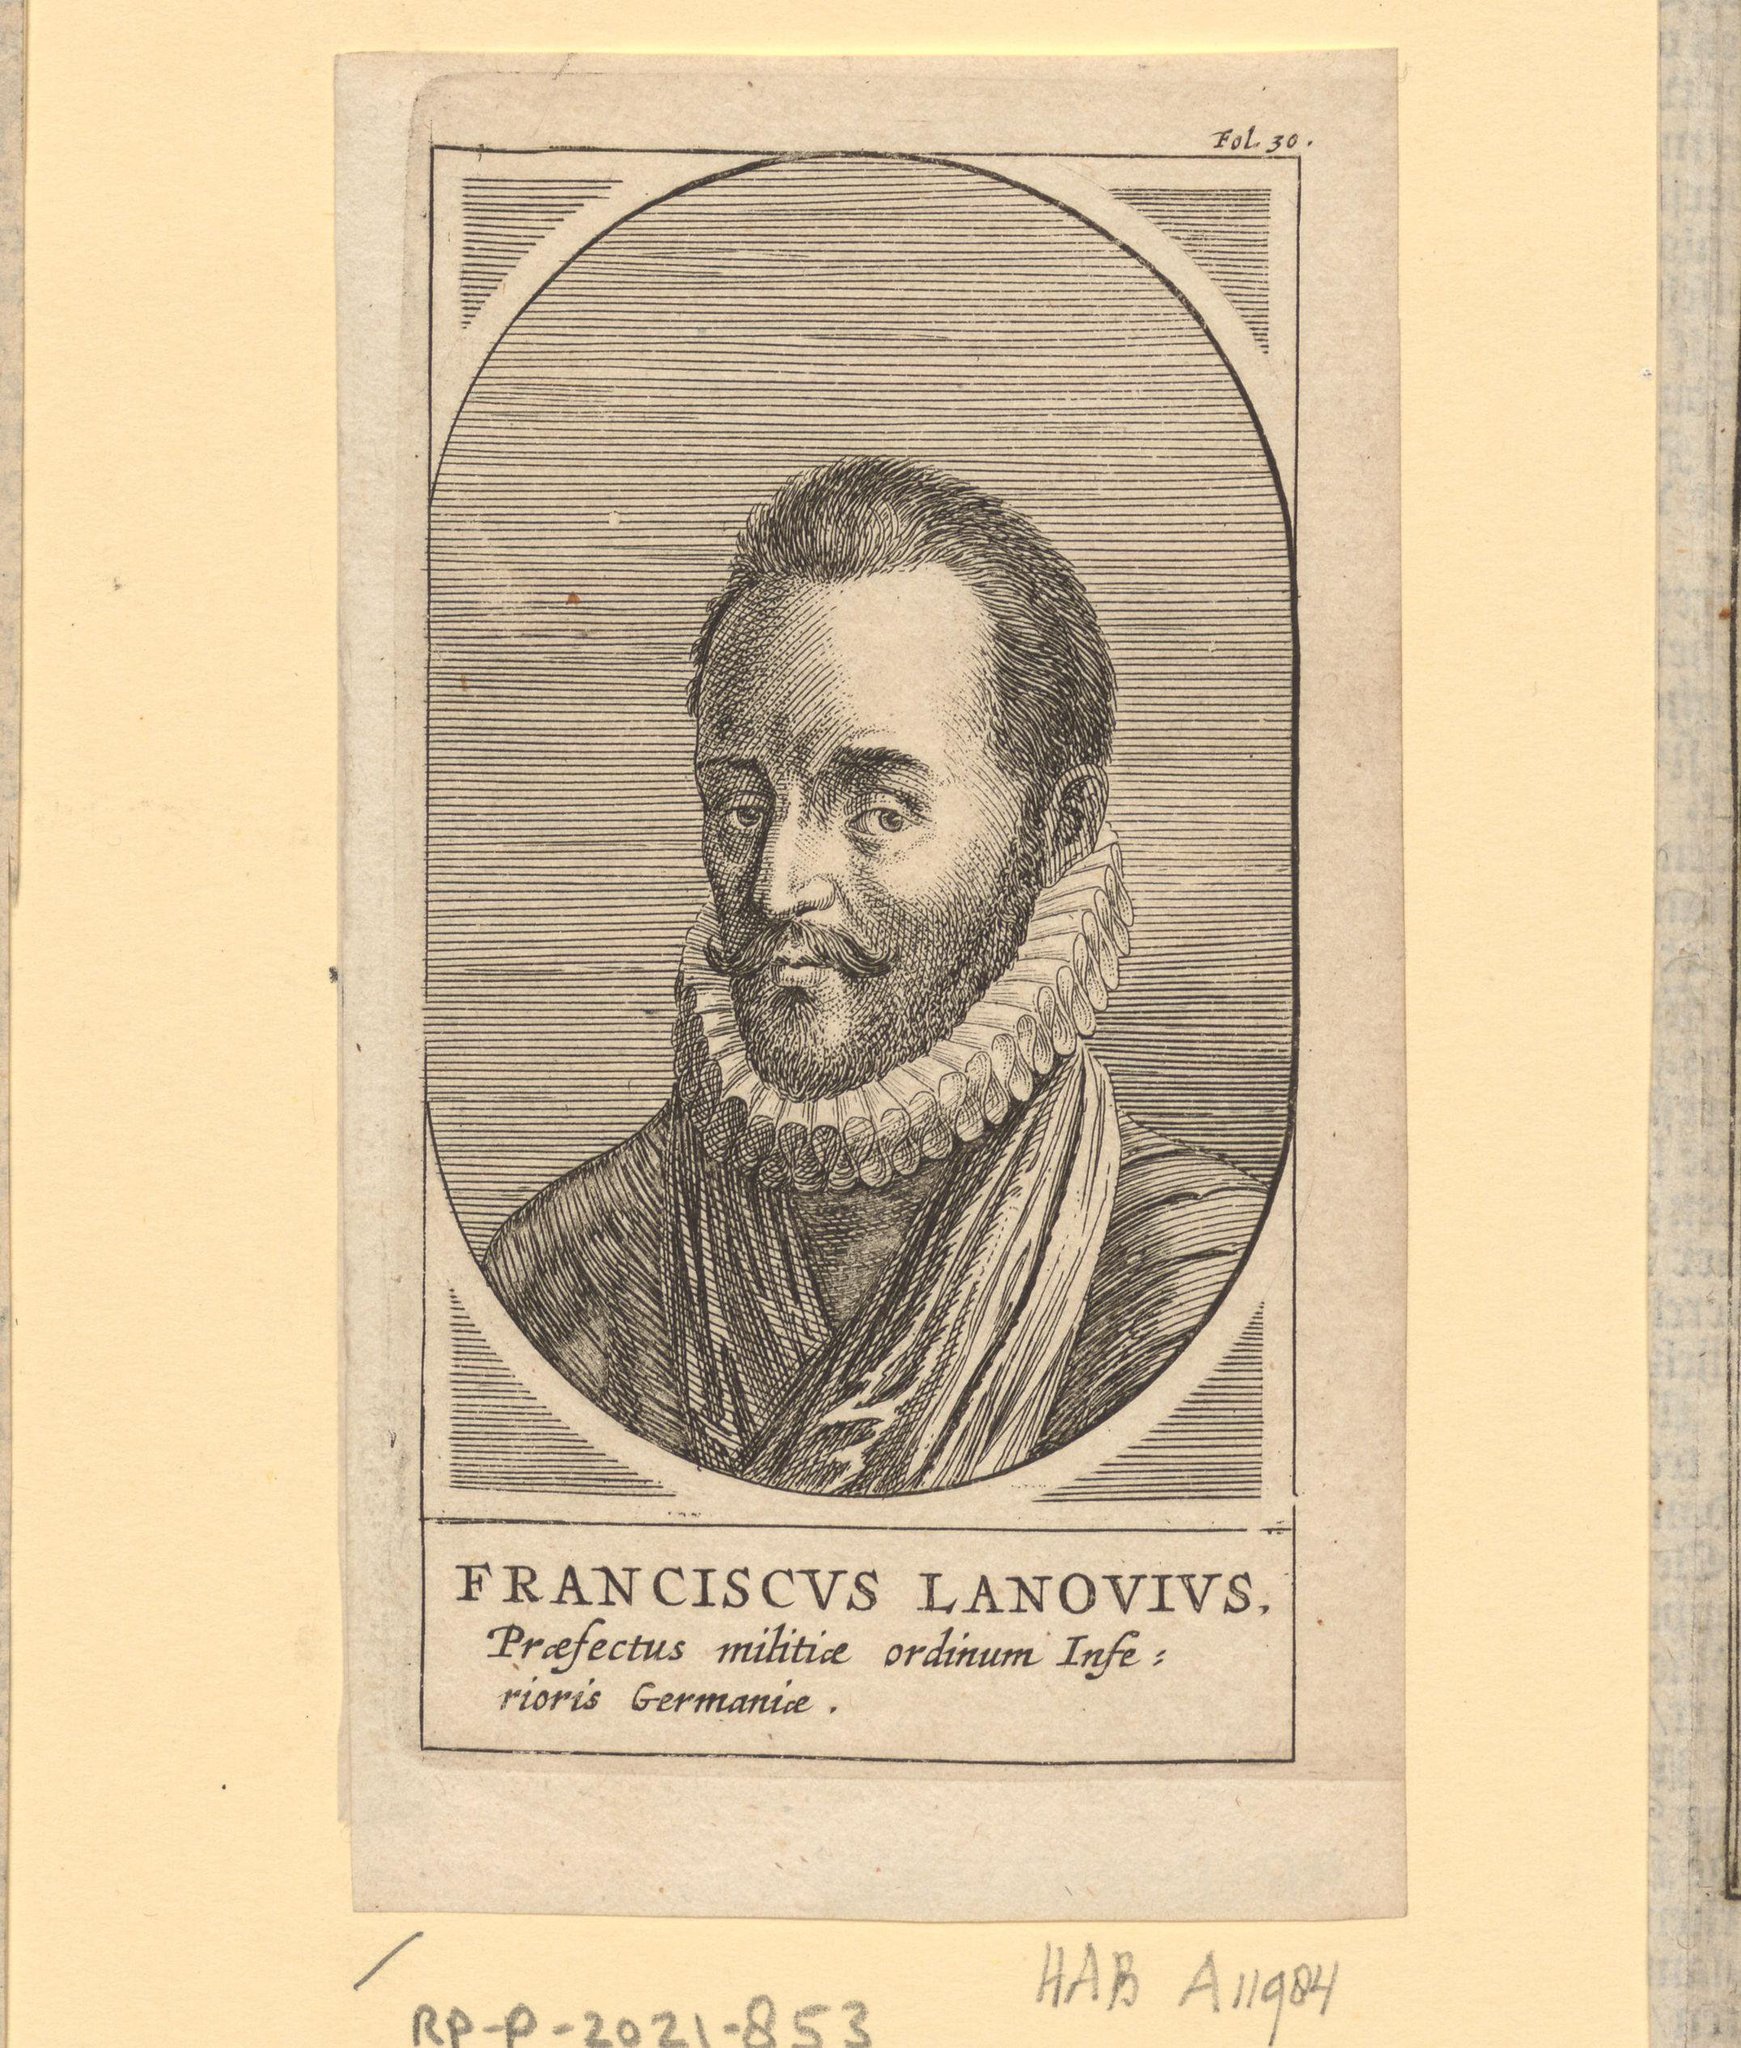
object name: book illustration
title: Portret van François de La Noue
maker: Anonymous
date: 1632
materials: paper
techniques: engraving, etching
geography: italy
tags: armour, historical persons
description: Prent waarschijnlijk uit: Strada, Famiano. De Bello Belgico (...). Rome: Francesco Corbelletti, 1632.